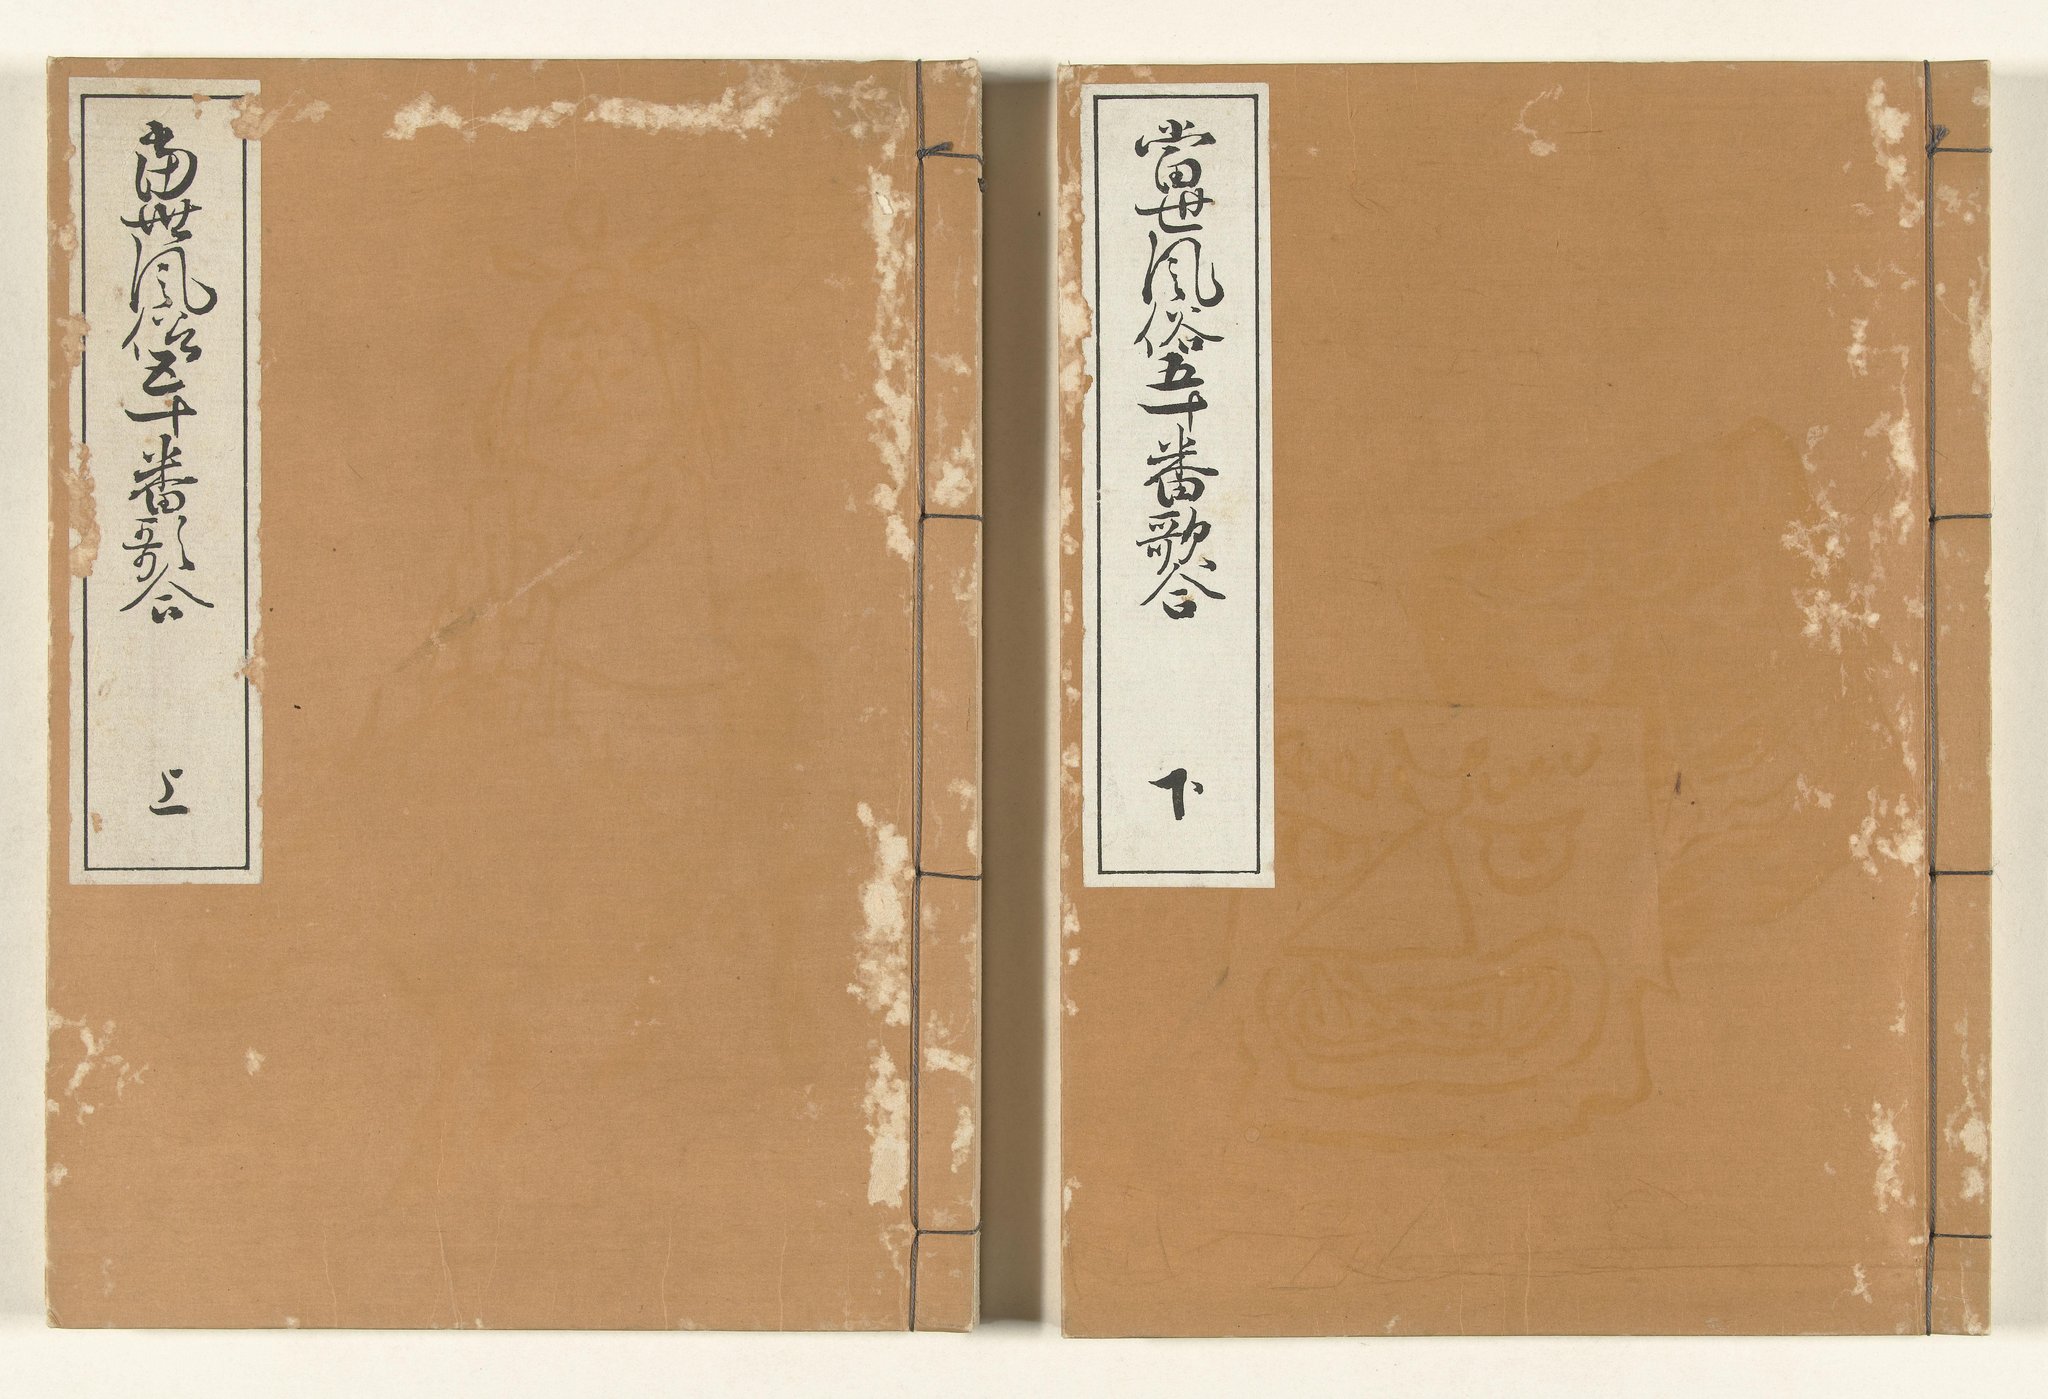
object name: book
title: Tosei fuzoku gojuban uta awase - jo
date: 1907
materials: paper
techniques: woodcut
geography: japan